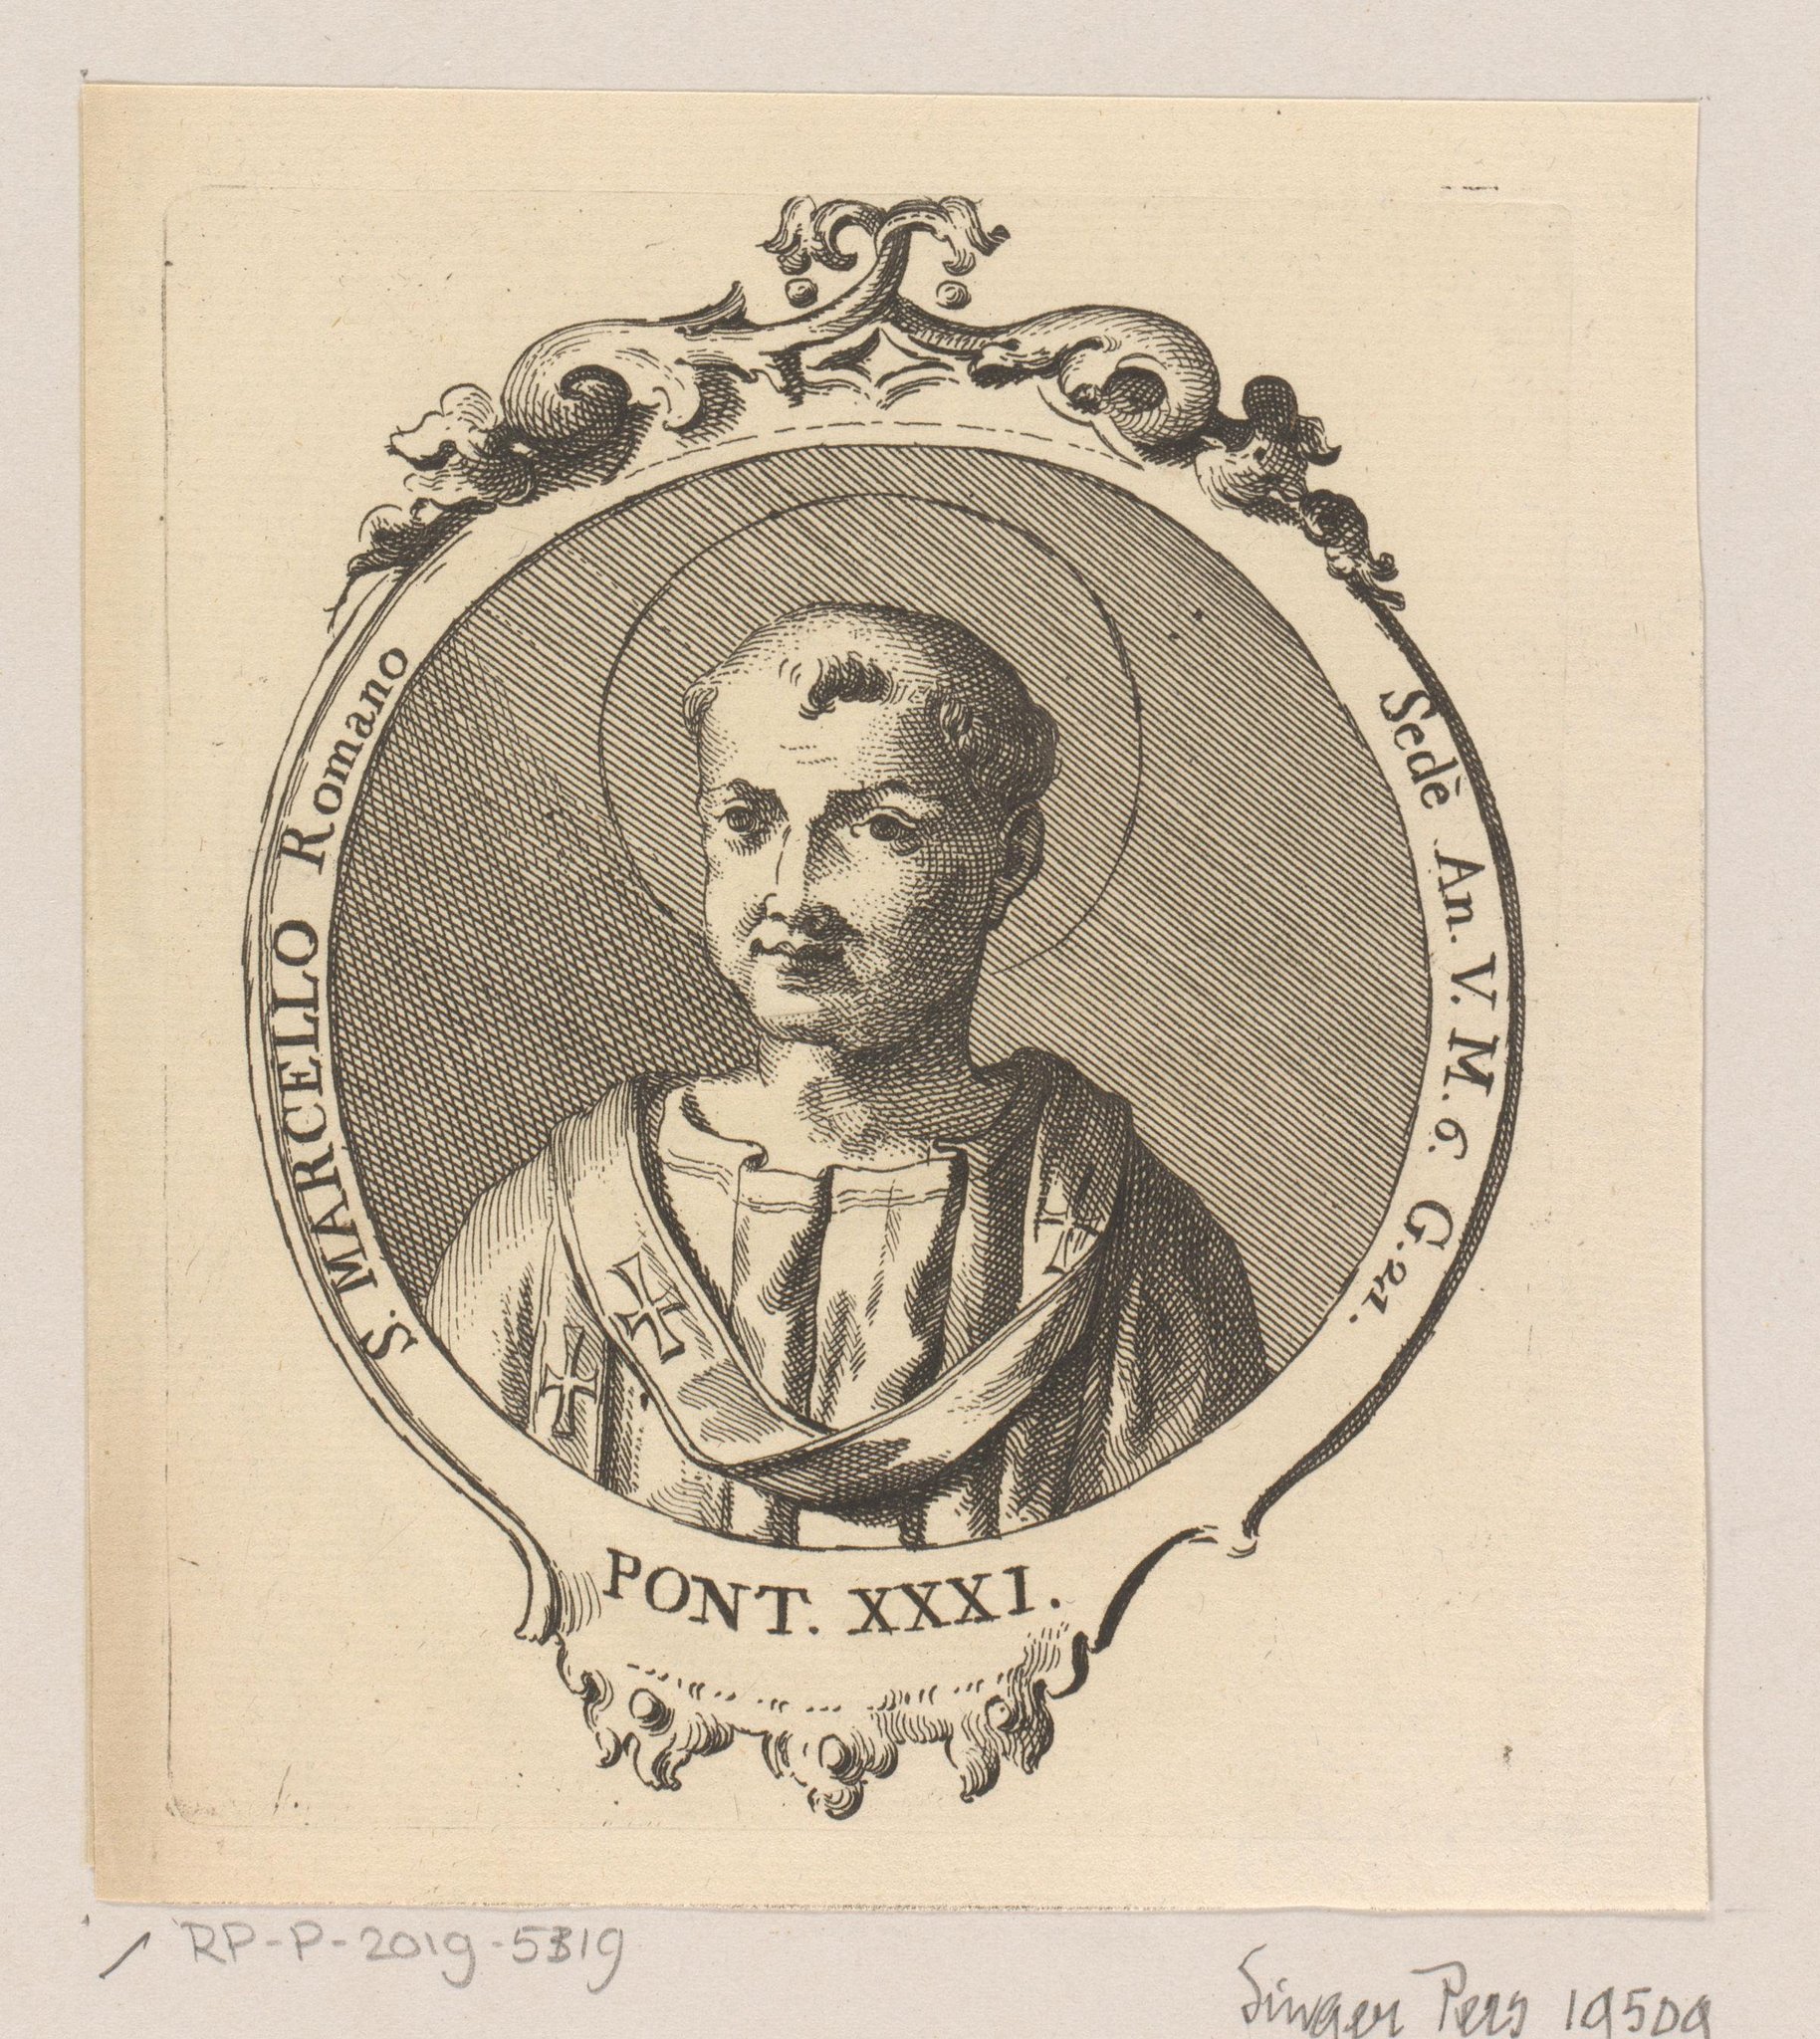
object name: book illustration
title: Portret van paus Marcellus I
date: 1775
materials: paper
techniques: engraving, etching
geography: venice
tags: rome, historical persons, pope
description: Prent uit: Effigies Romanorum pontificum a S. Petro ad Pium VI. feliciter regnantem (...). 2 dln. Venetië en Bassano del Grappa: Giuseppe Remondini, 1775.